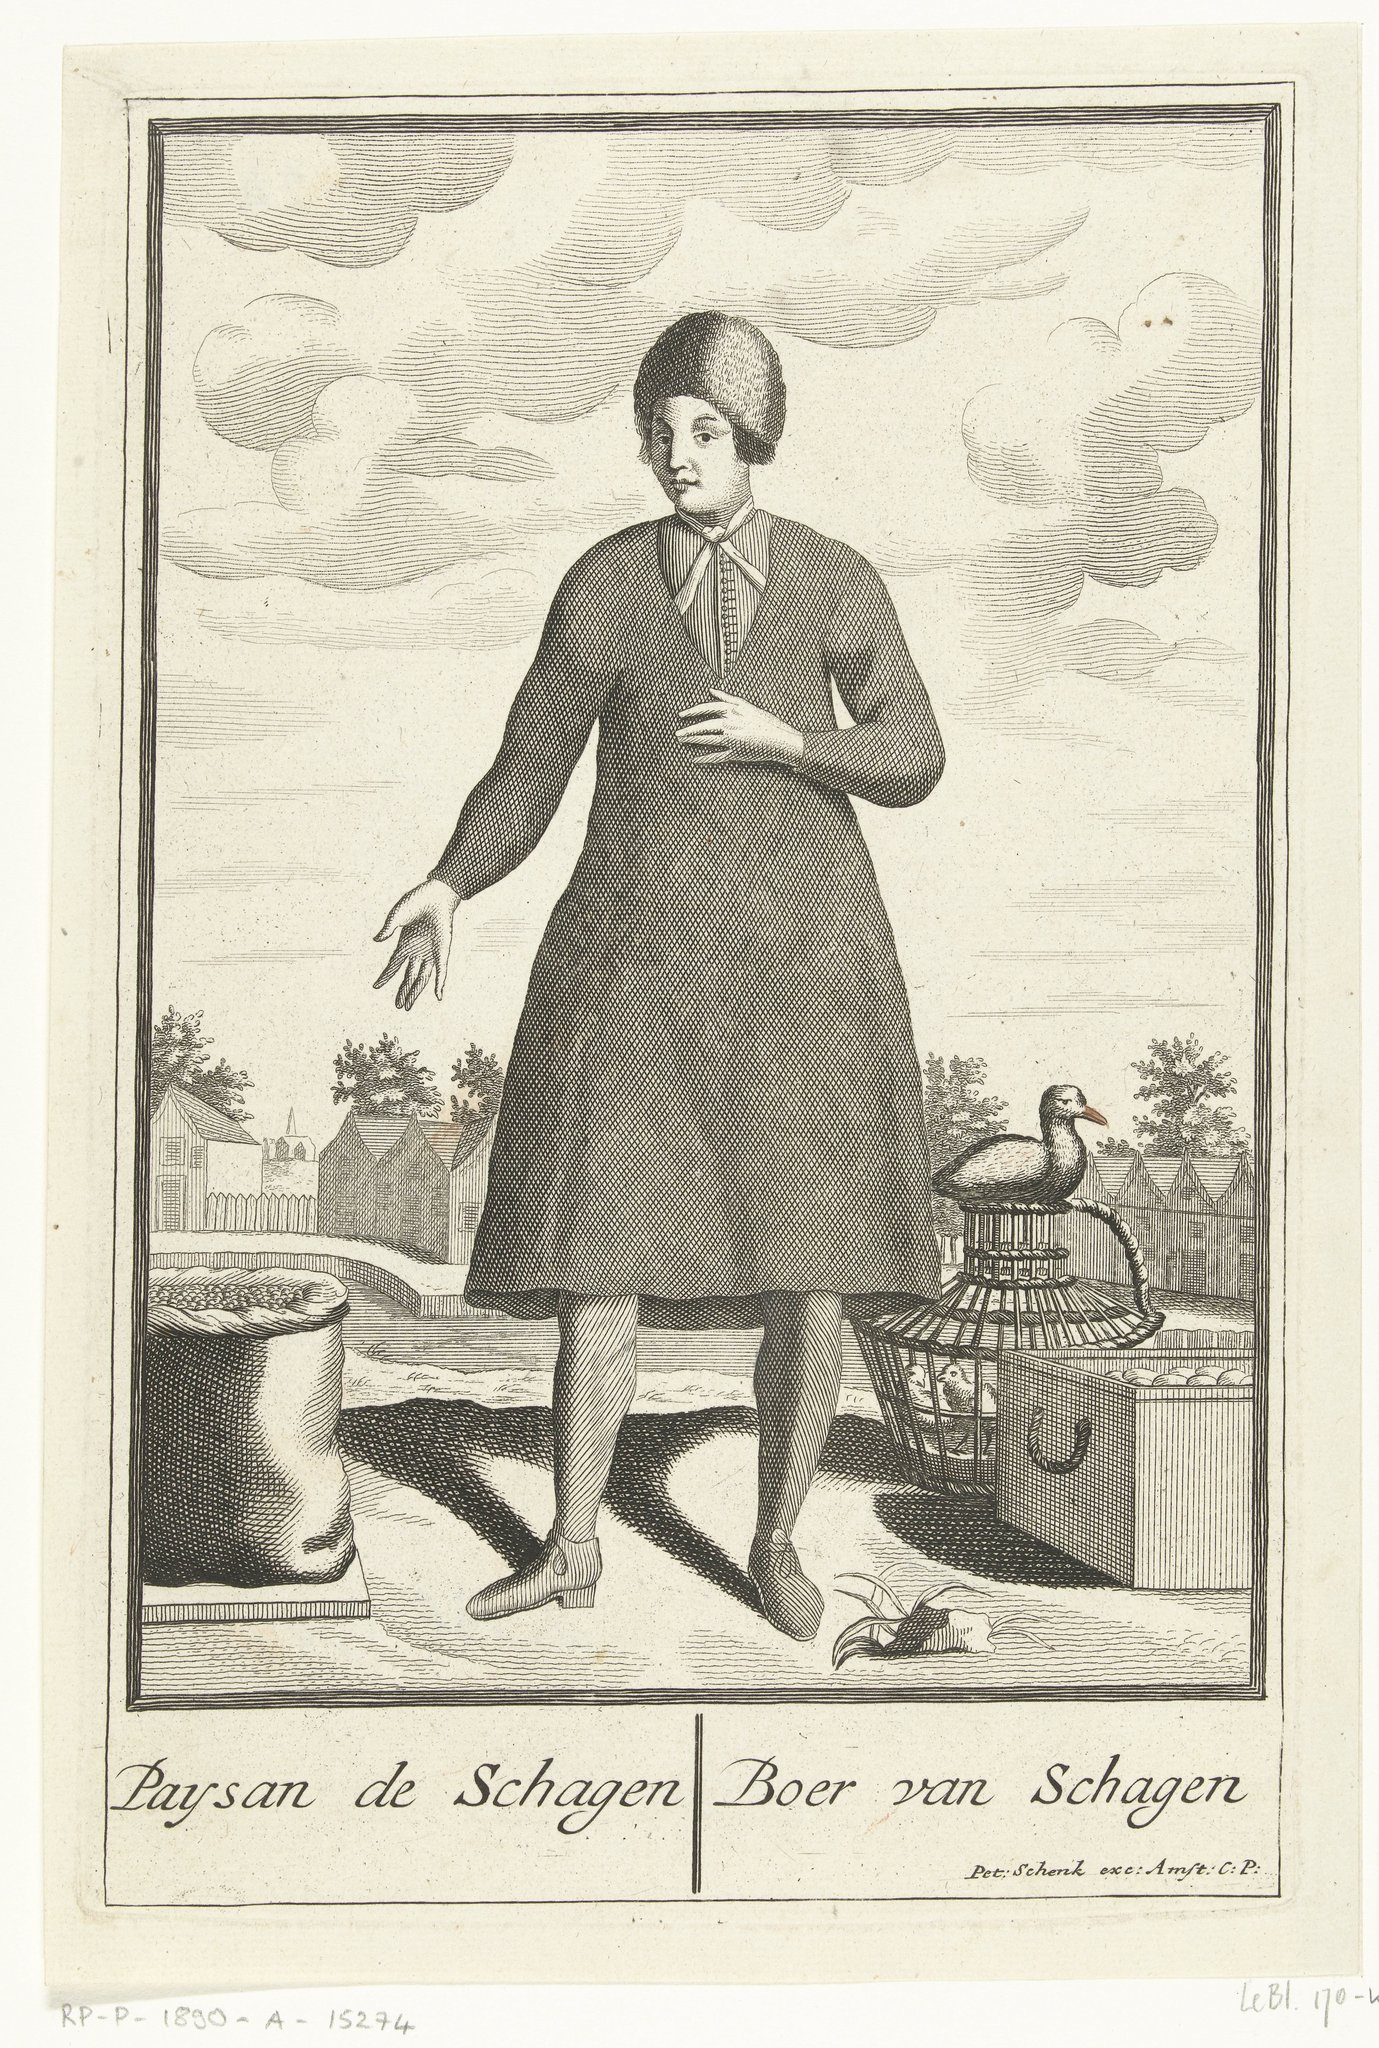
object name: print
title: Nederlandse klederdrachten naar Pieter van den Berge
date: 1689-1713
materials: paper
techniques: engraving, etching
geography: amsterdam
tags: farmers, folk costume, regional costume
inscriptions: collector's mark: Lugt 2228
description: Een man gekleed in een visserspij staat aan het water tussen koopwaar. Op de achtergrond een rij huisjes. Prent uit een serie prenten naar Pieter van den Berge met dorpelingen die klederdrachten dragen.